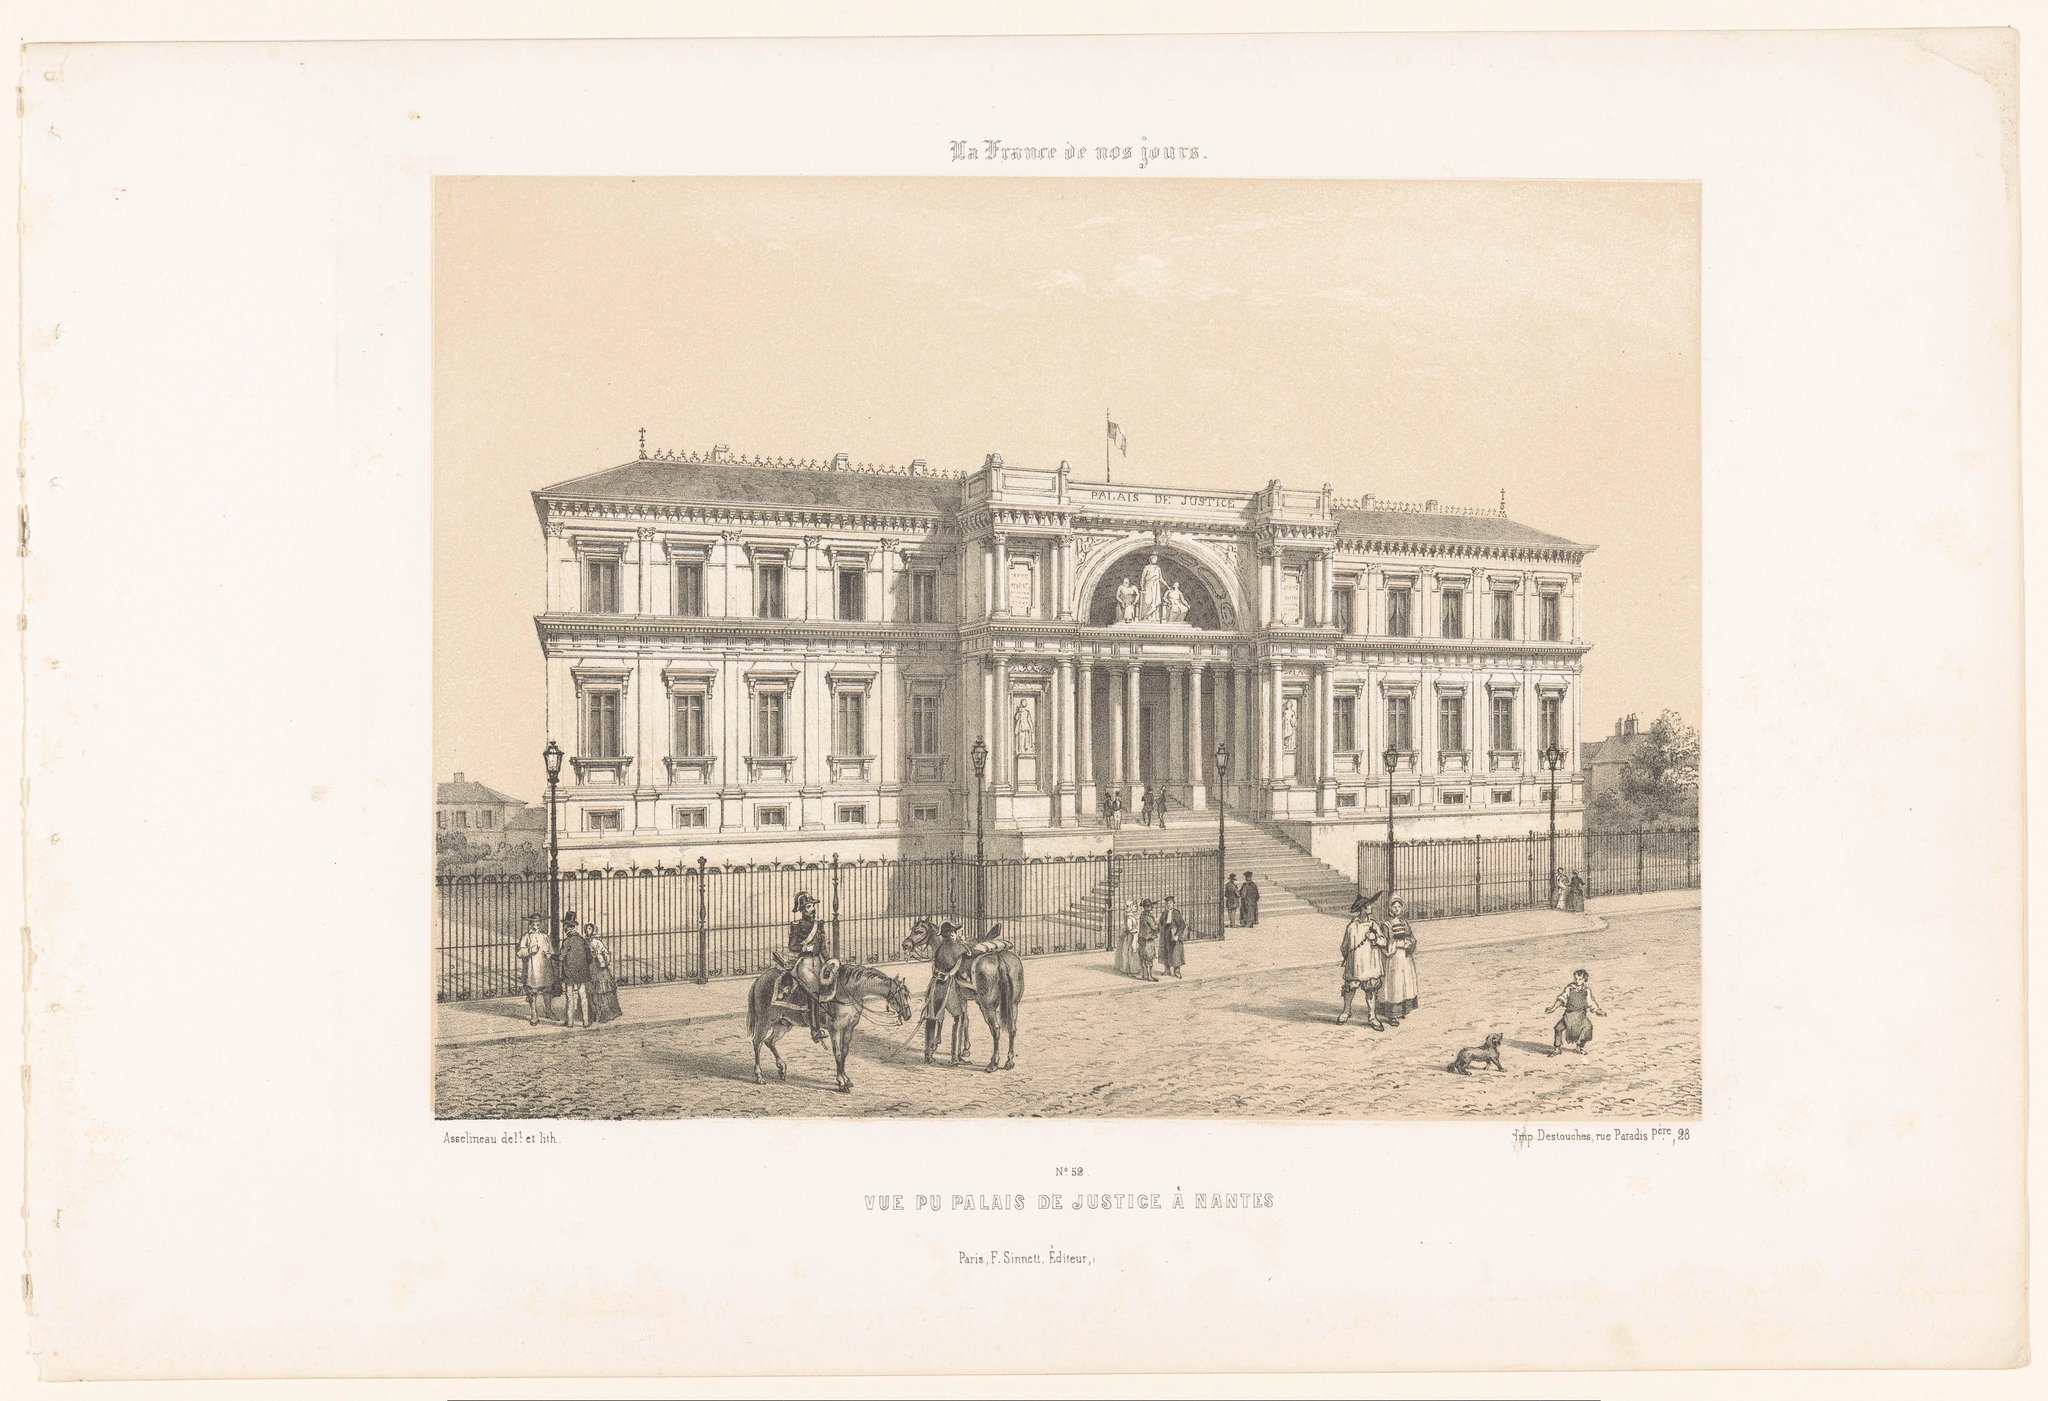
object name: print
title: Hedendaags Frankrijk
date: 1853-1856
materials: paper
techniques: tone lithography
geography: rouen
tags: court building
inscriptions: collector's mark: Lugt 2228